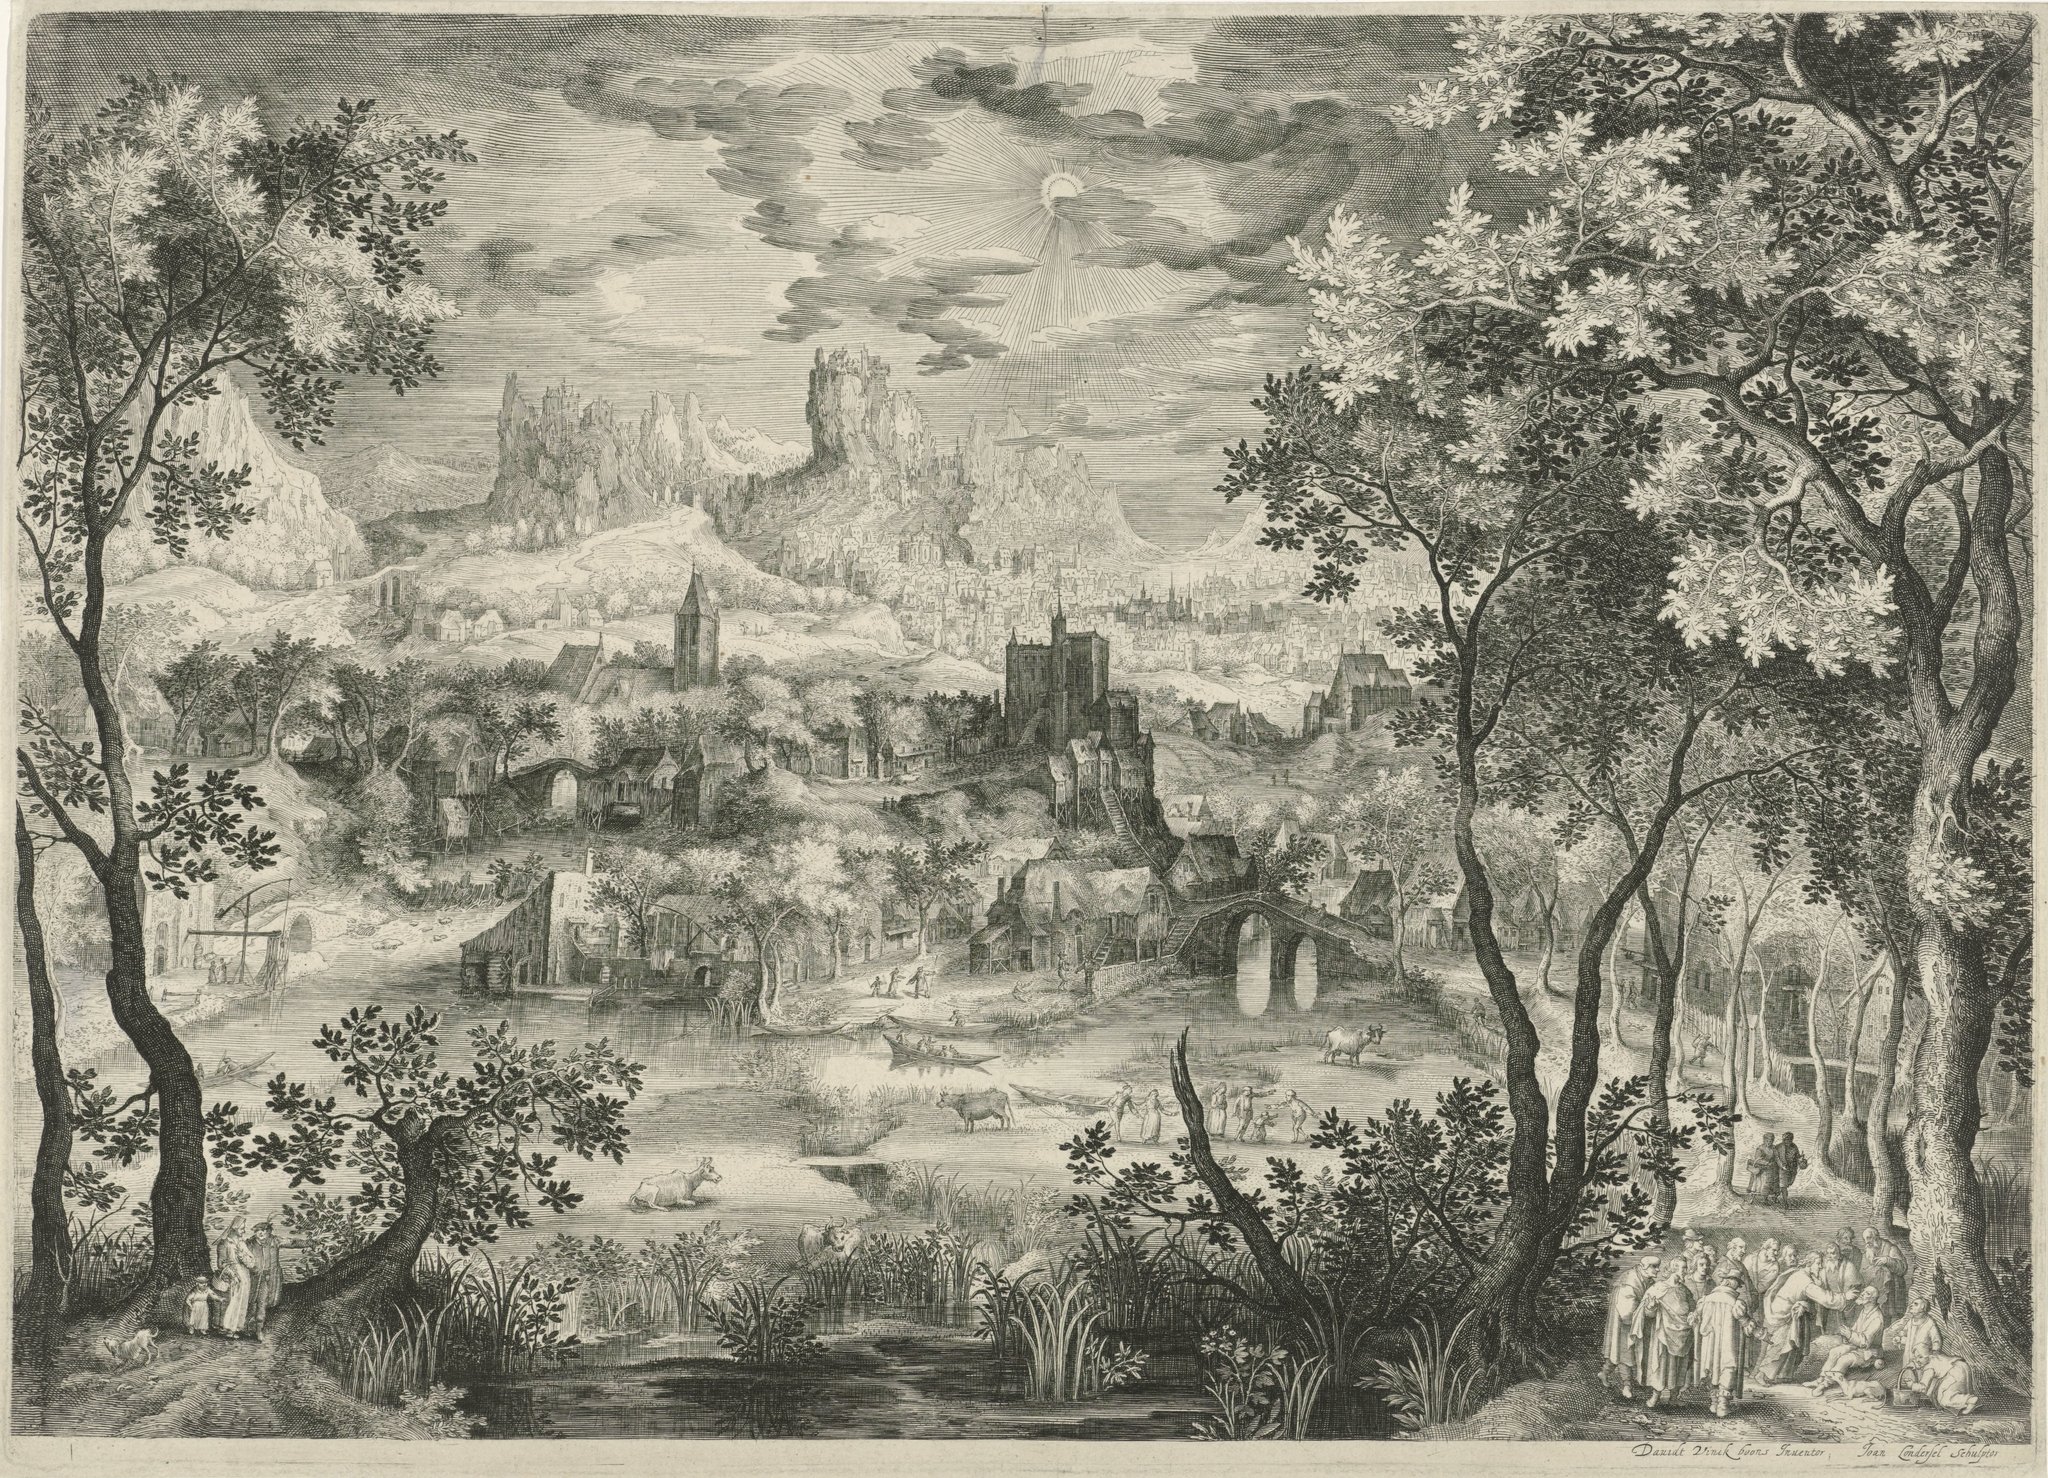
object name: print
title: Landscape with the Healing of the Blind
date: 1601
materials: paper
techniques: engraving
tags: swamp, inland marsh, fens, healing of a man born blind: christ touches his eyes with an 'ointment' of dust and spittle (john 9)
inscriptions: collector's mark: Lugt 2228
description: This print was made after the adjacent drawing of 1601. This engraving and the other prints in the series must have been popular among art buyers. Besides vivid and richly contrasted impressions, grey and dull ones have also been preserved: proof that the copper plates were run through the press hundreds of times.